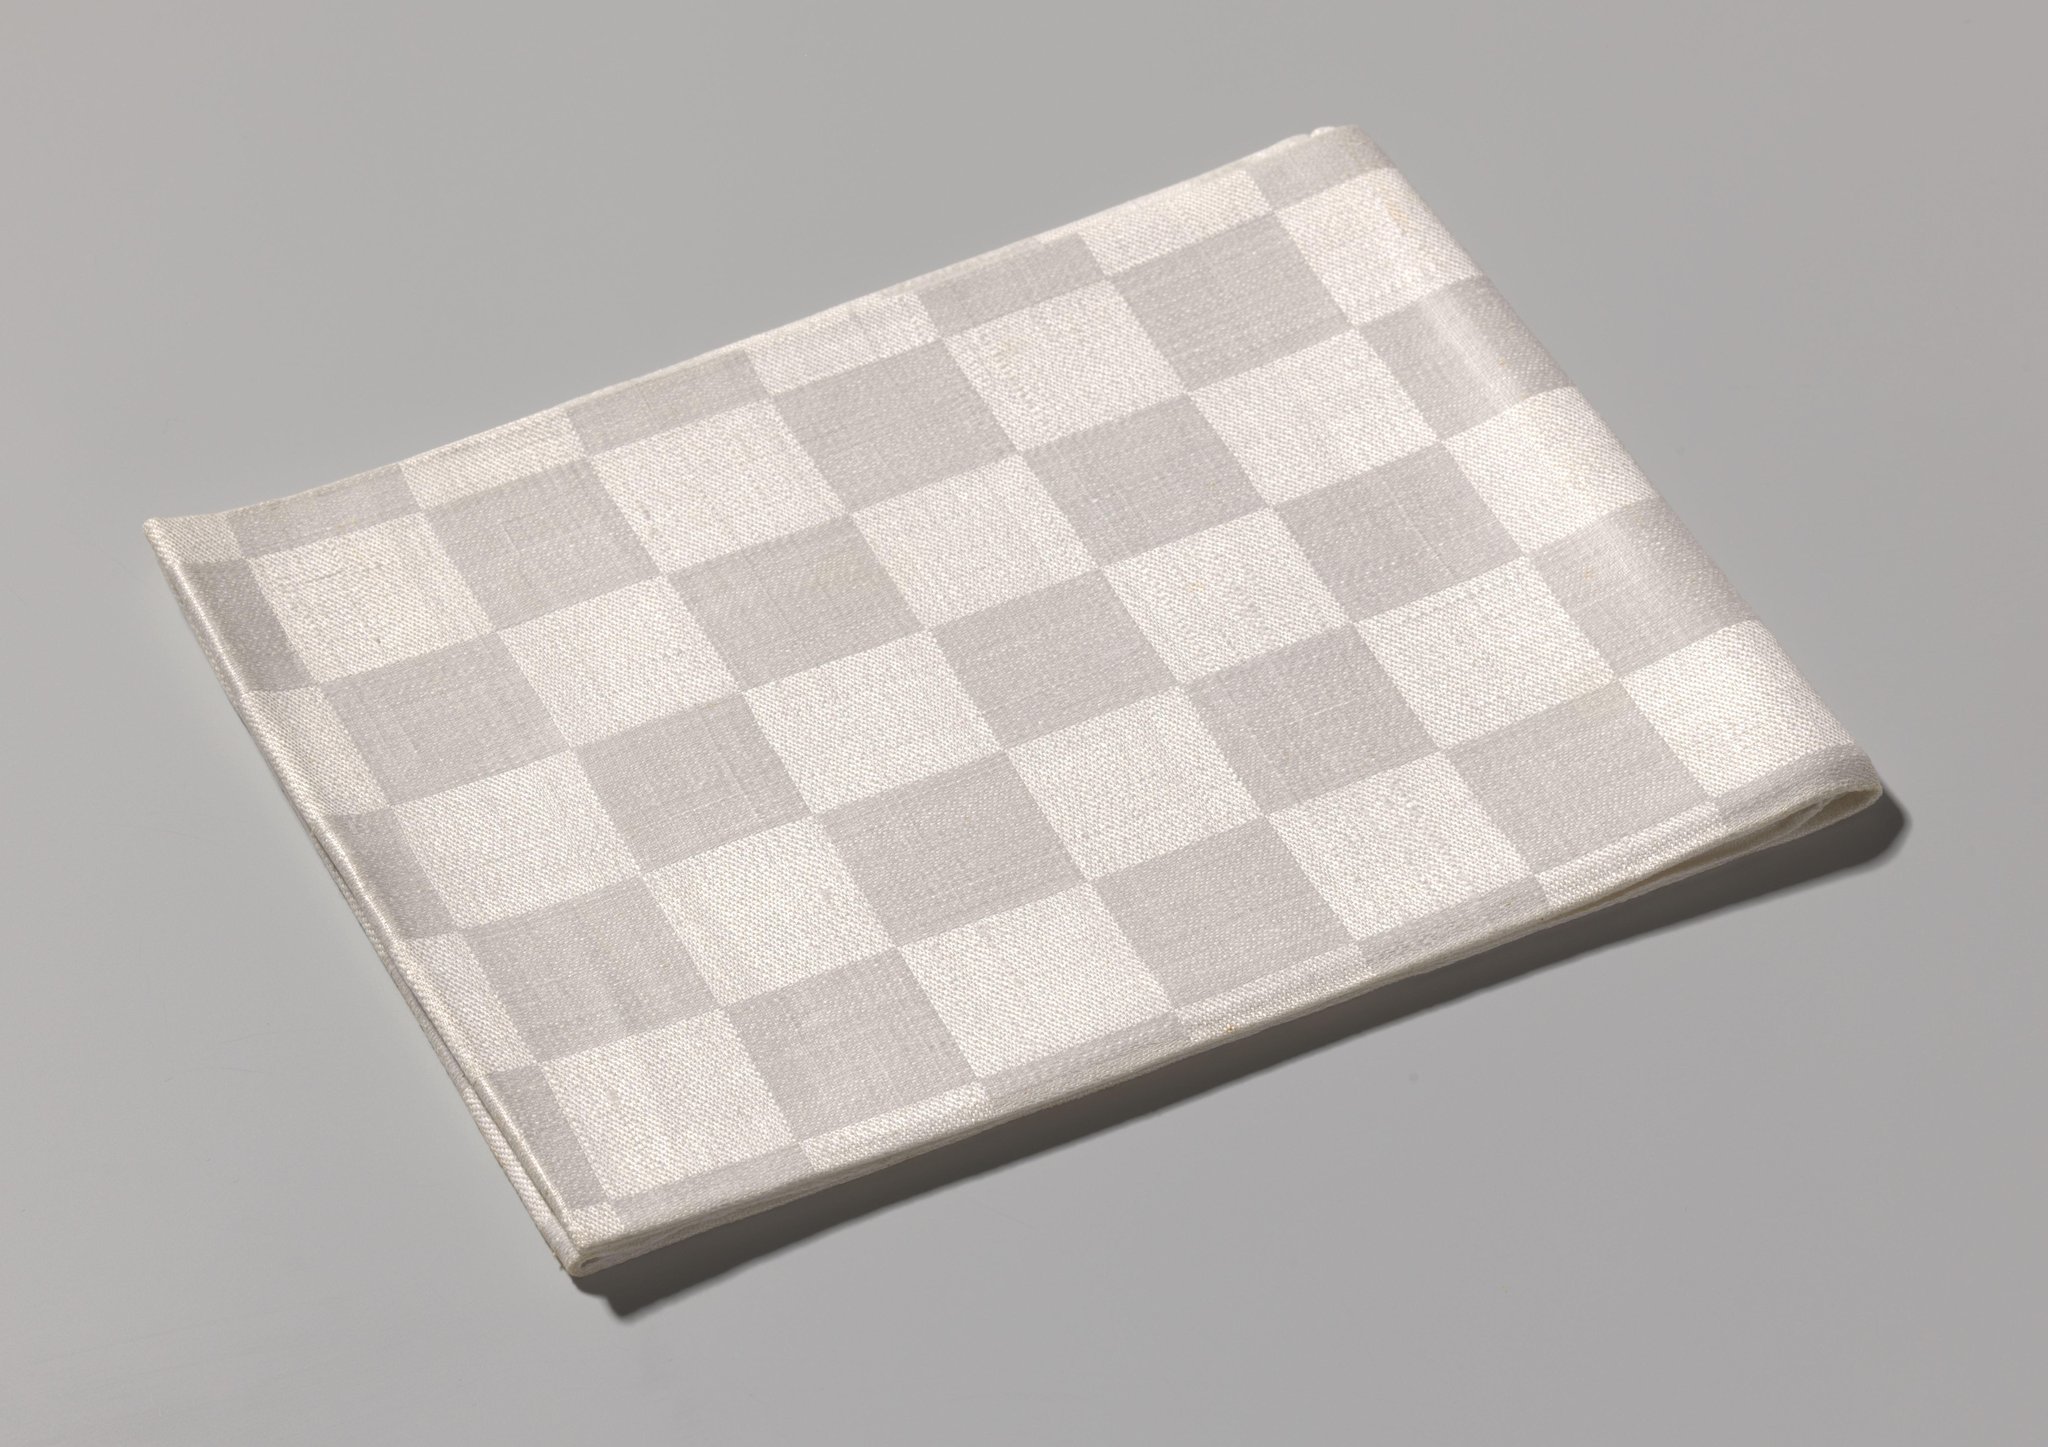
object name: napkin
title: Servet van linnen met pellenpatroon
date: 1830-1870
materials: linen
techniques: peeled fabric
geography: northern netherlands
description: Wit linnen servet met pellenpatroon, merk HW 80.